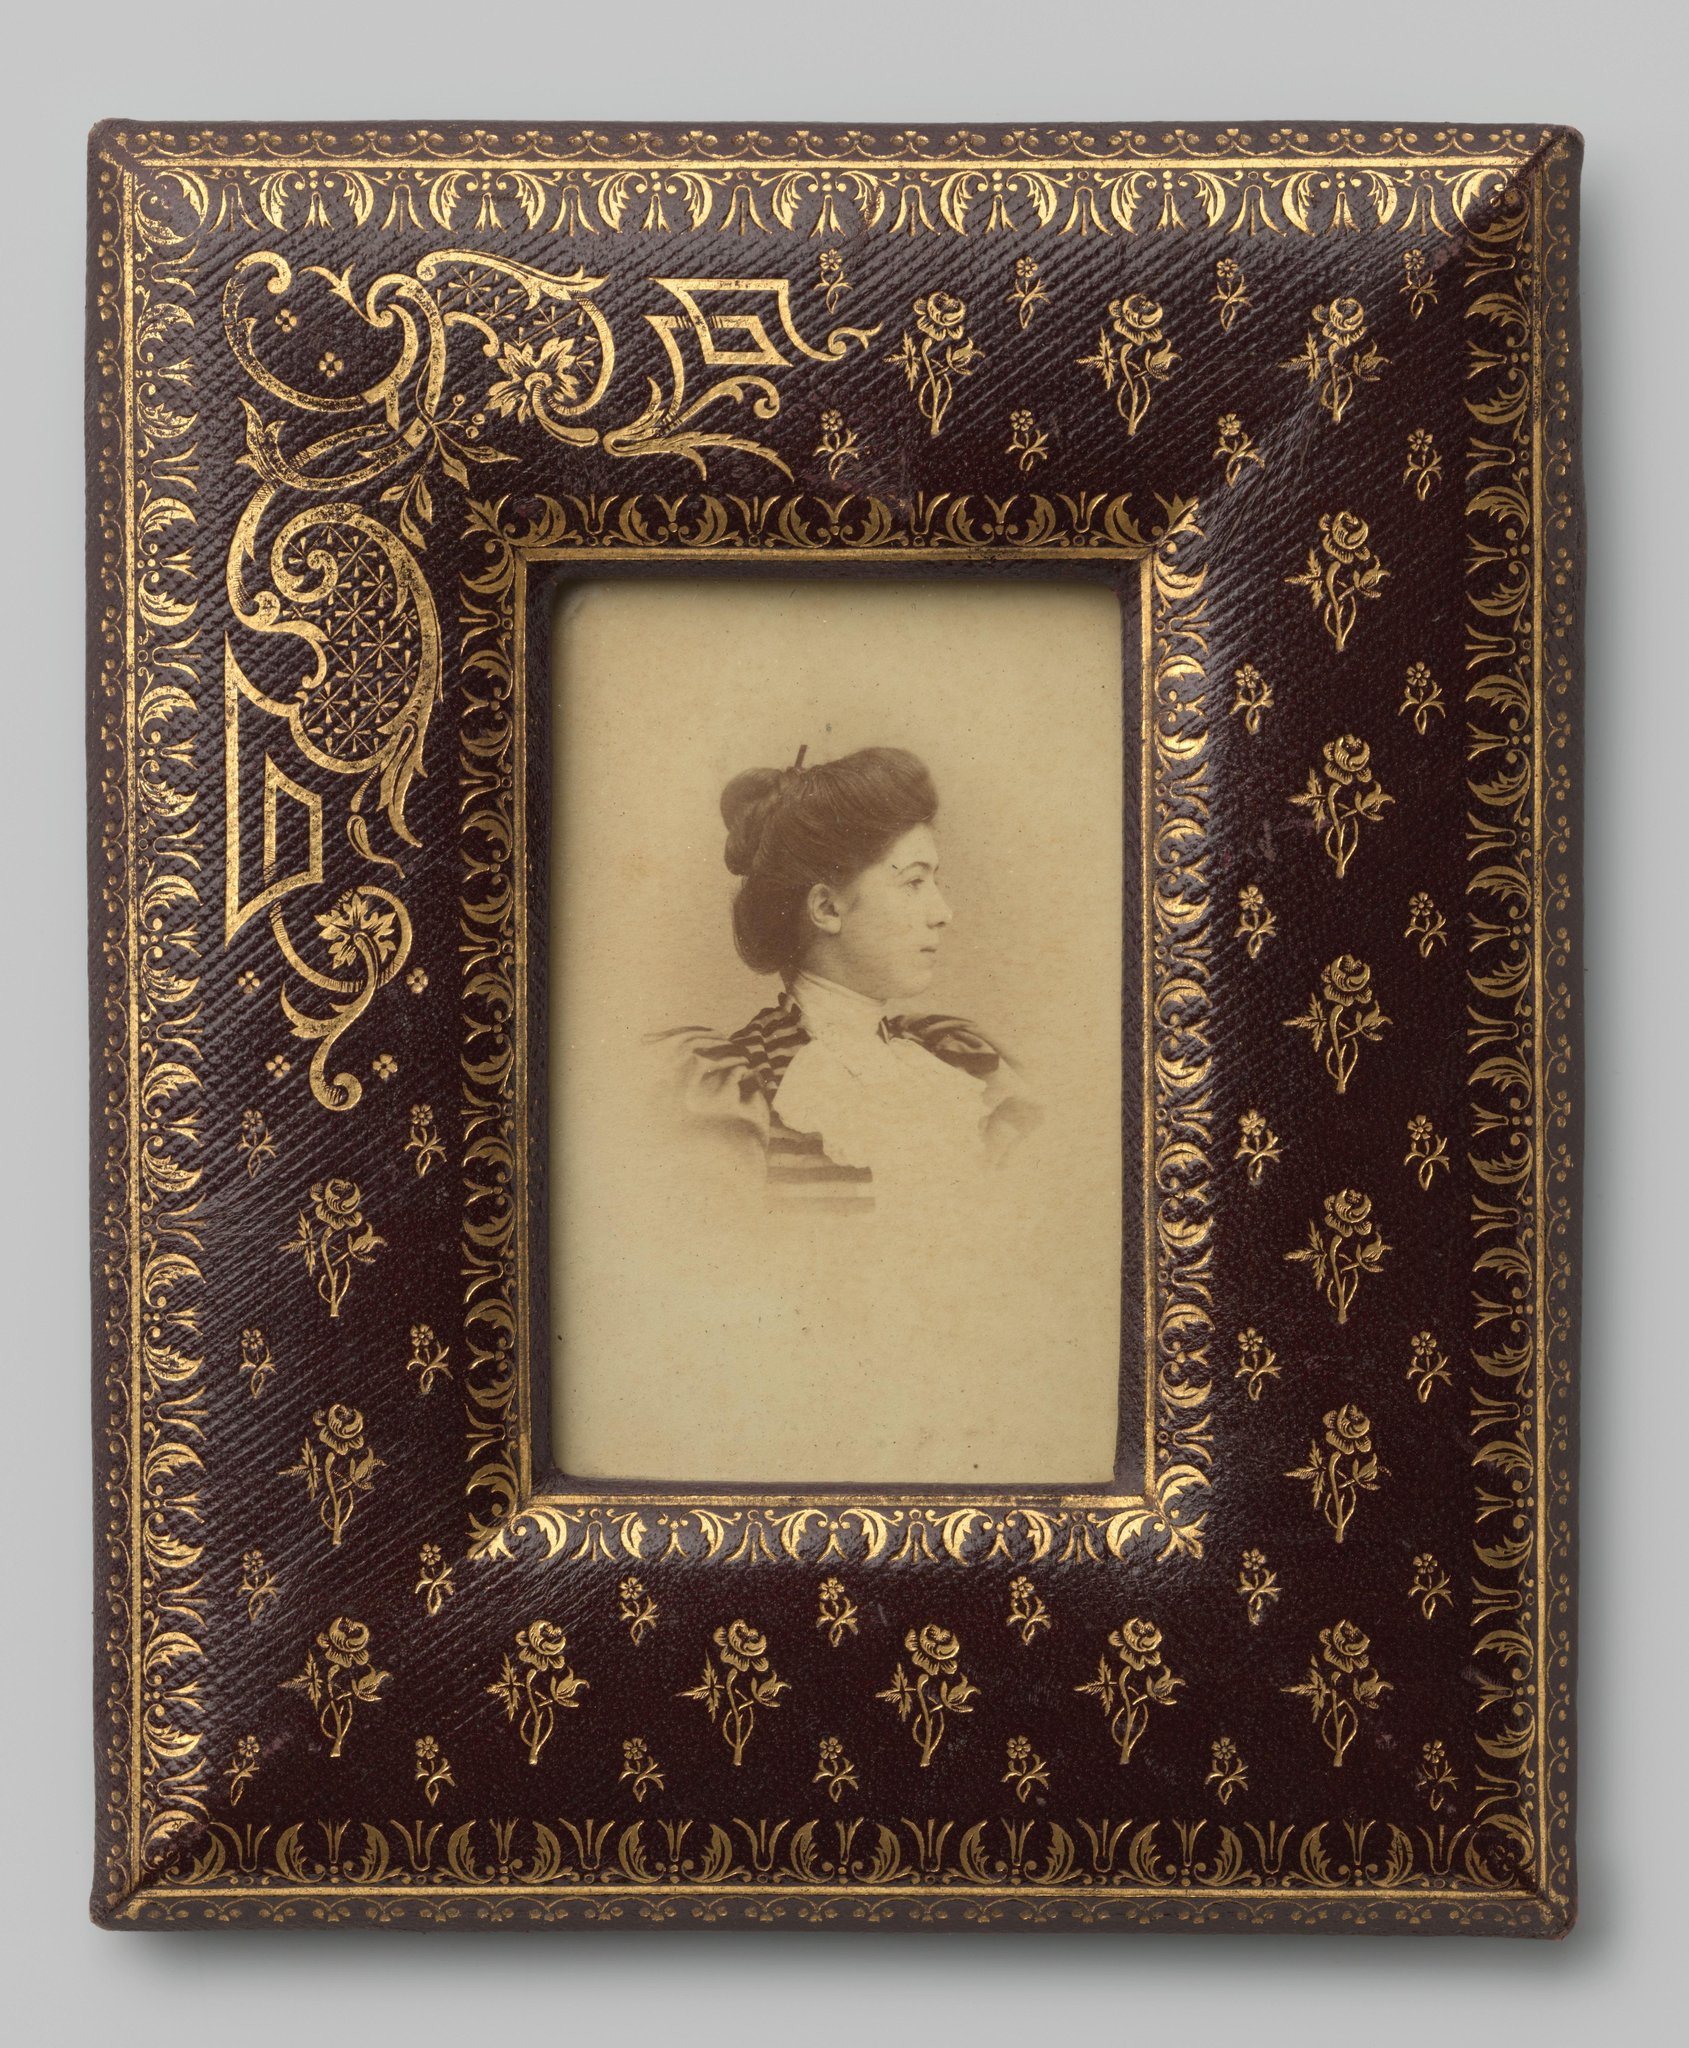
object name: photograph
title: Portret van een onbekende vrouw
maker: Anonymous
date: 1880-1900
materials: cardboard, glass, leather, metal, paper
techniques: albumen print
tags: adult woman, anonymous historical person portrayed